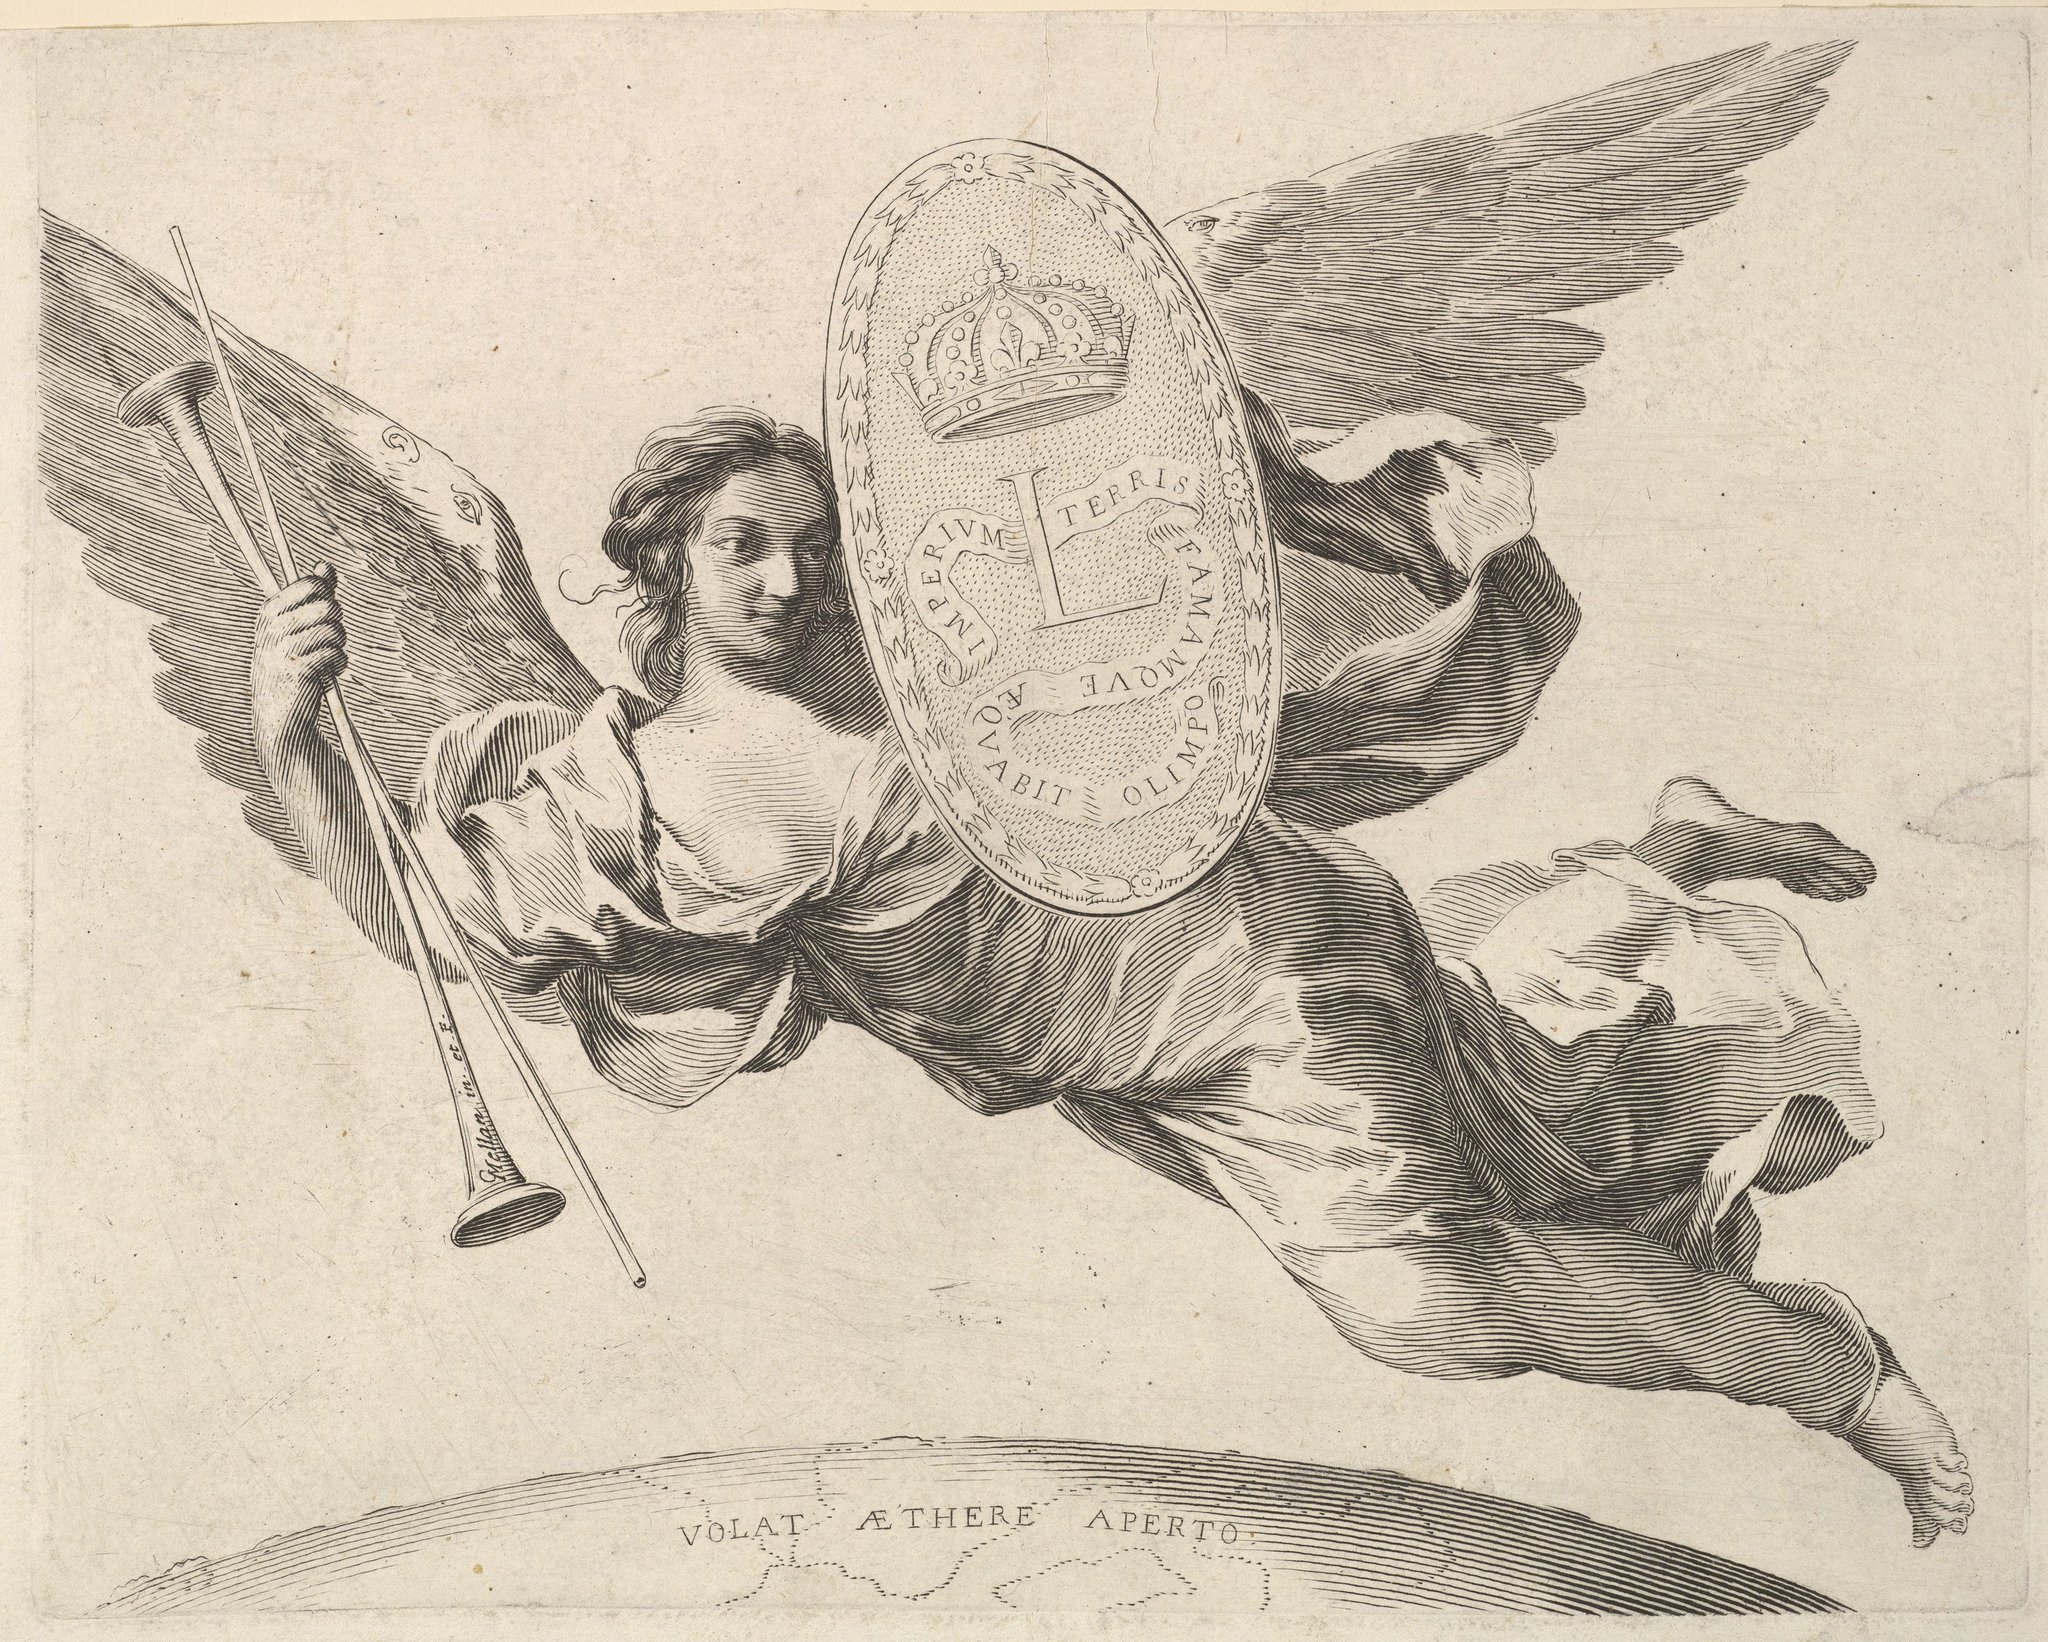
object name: print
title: Fame Bearing a Shield with the Initial of Louis XIV (La Renommée volant)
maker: claude mellan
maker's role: artist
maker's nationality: french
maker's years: 1598-1688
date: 1600-1688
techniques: engraving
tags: shields,insignia